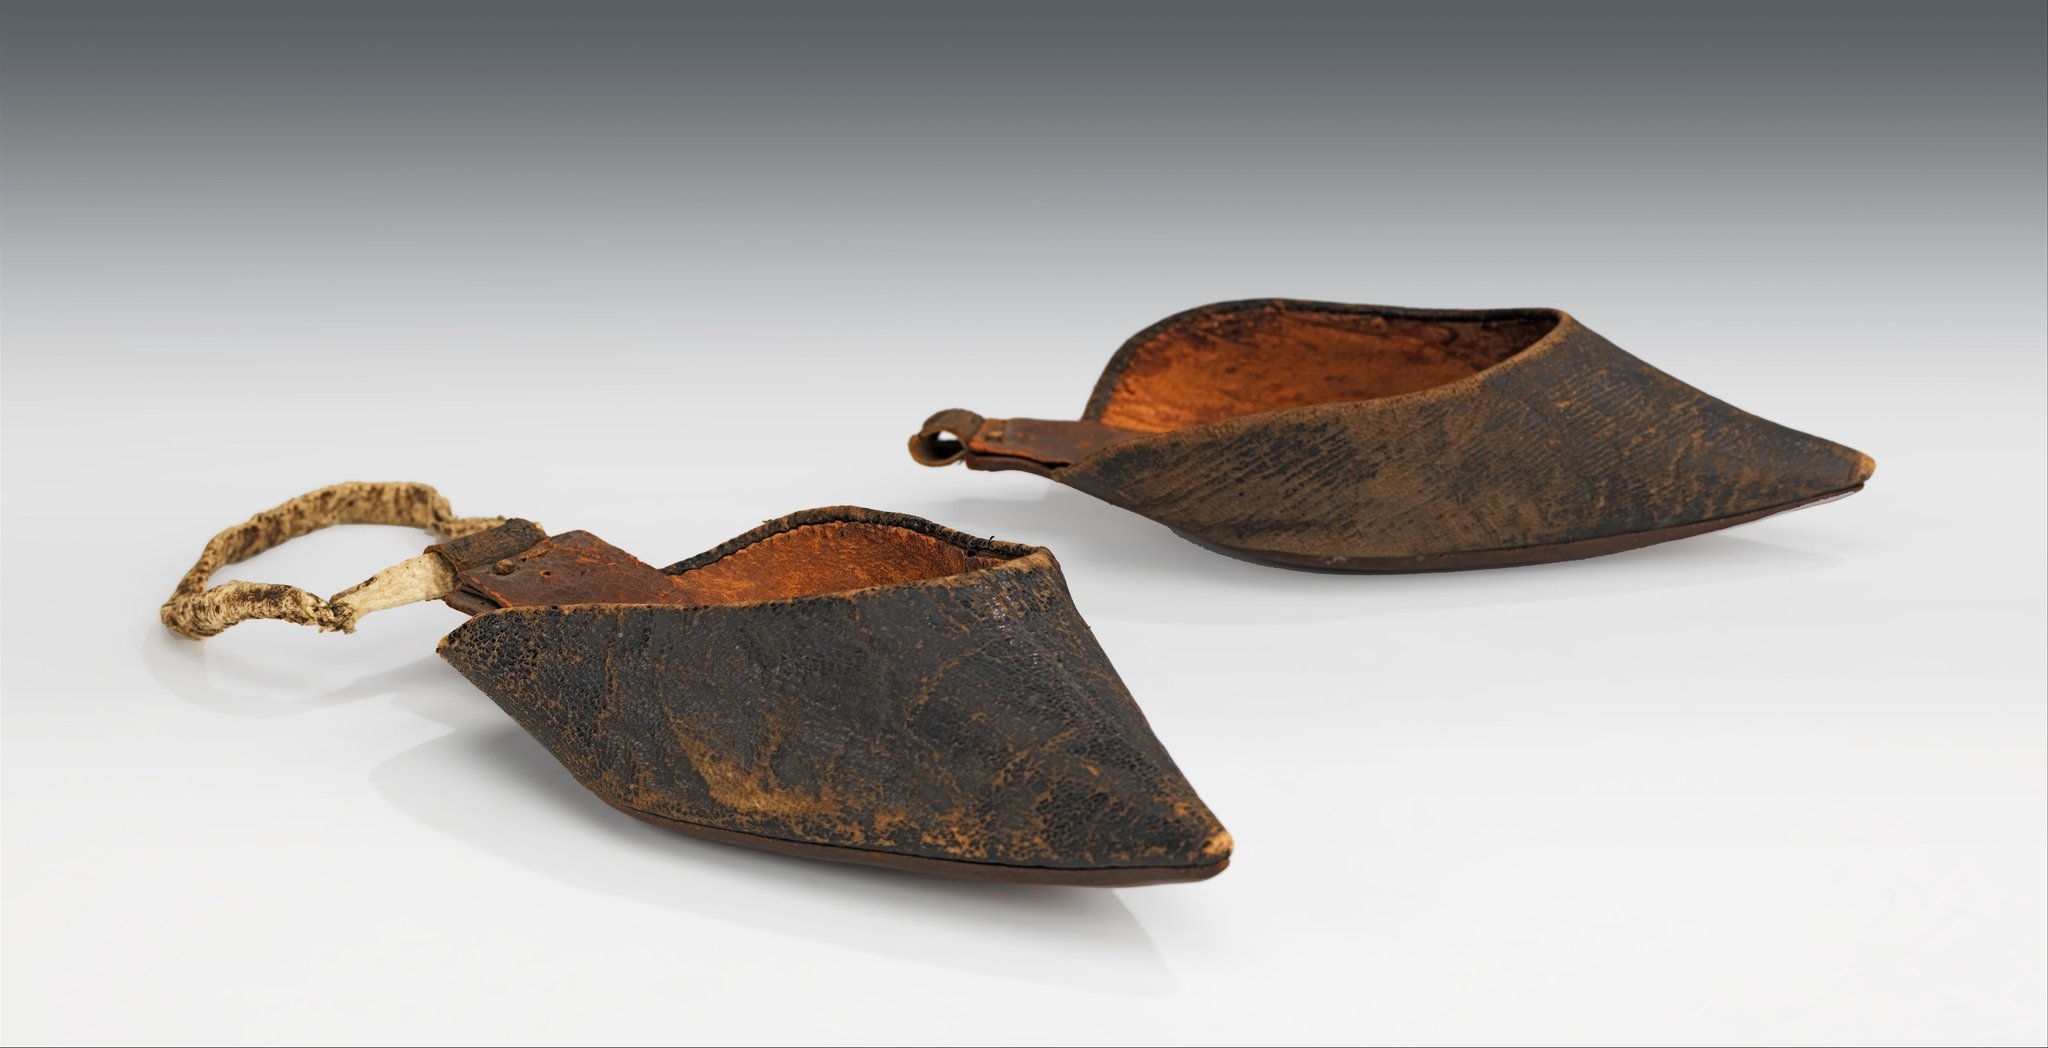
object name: overshoe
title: Overshoes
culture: european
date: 1790-1810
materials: leather